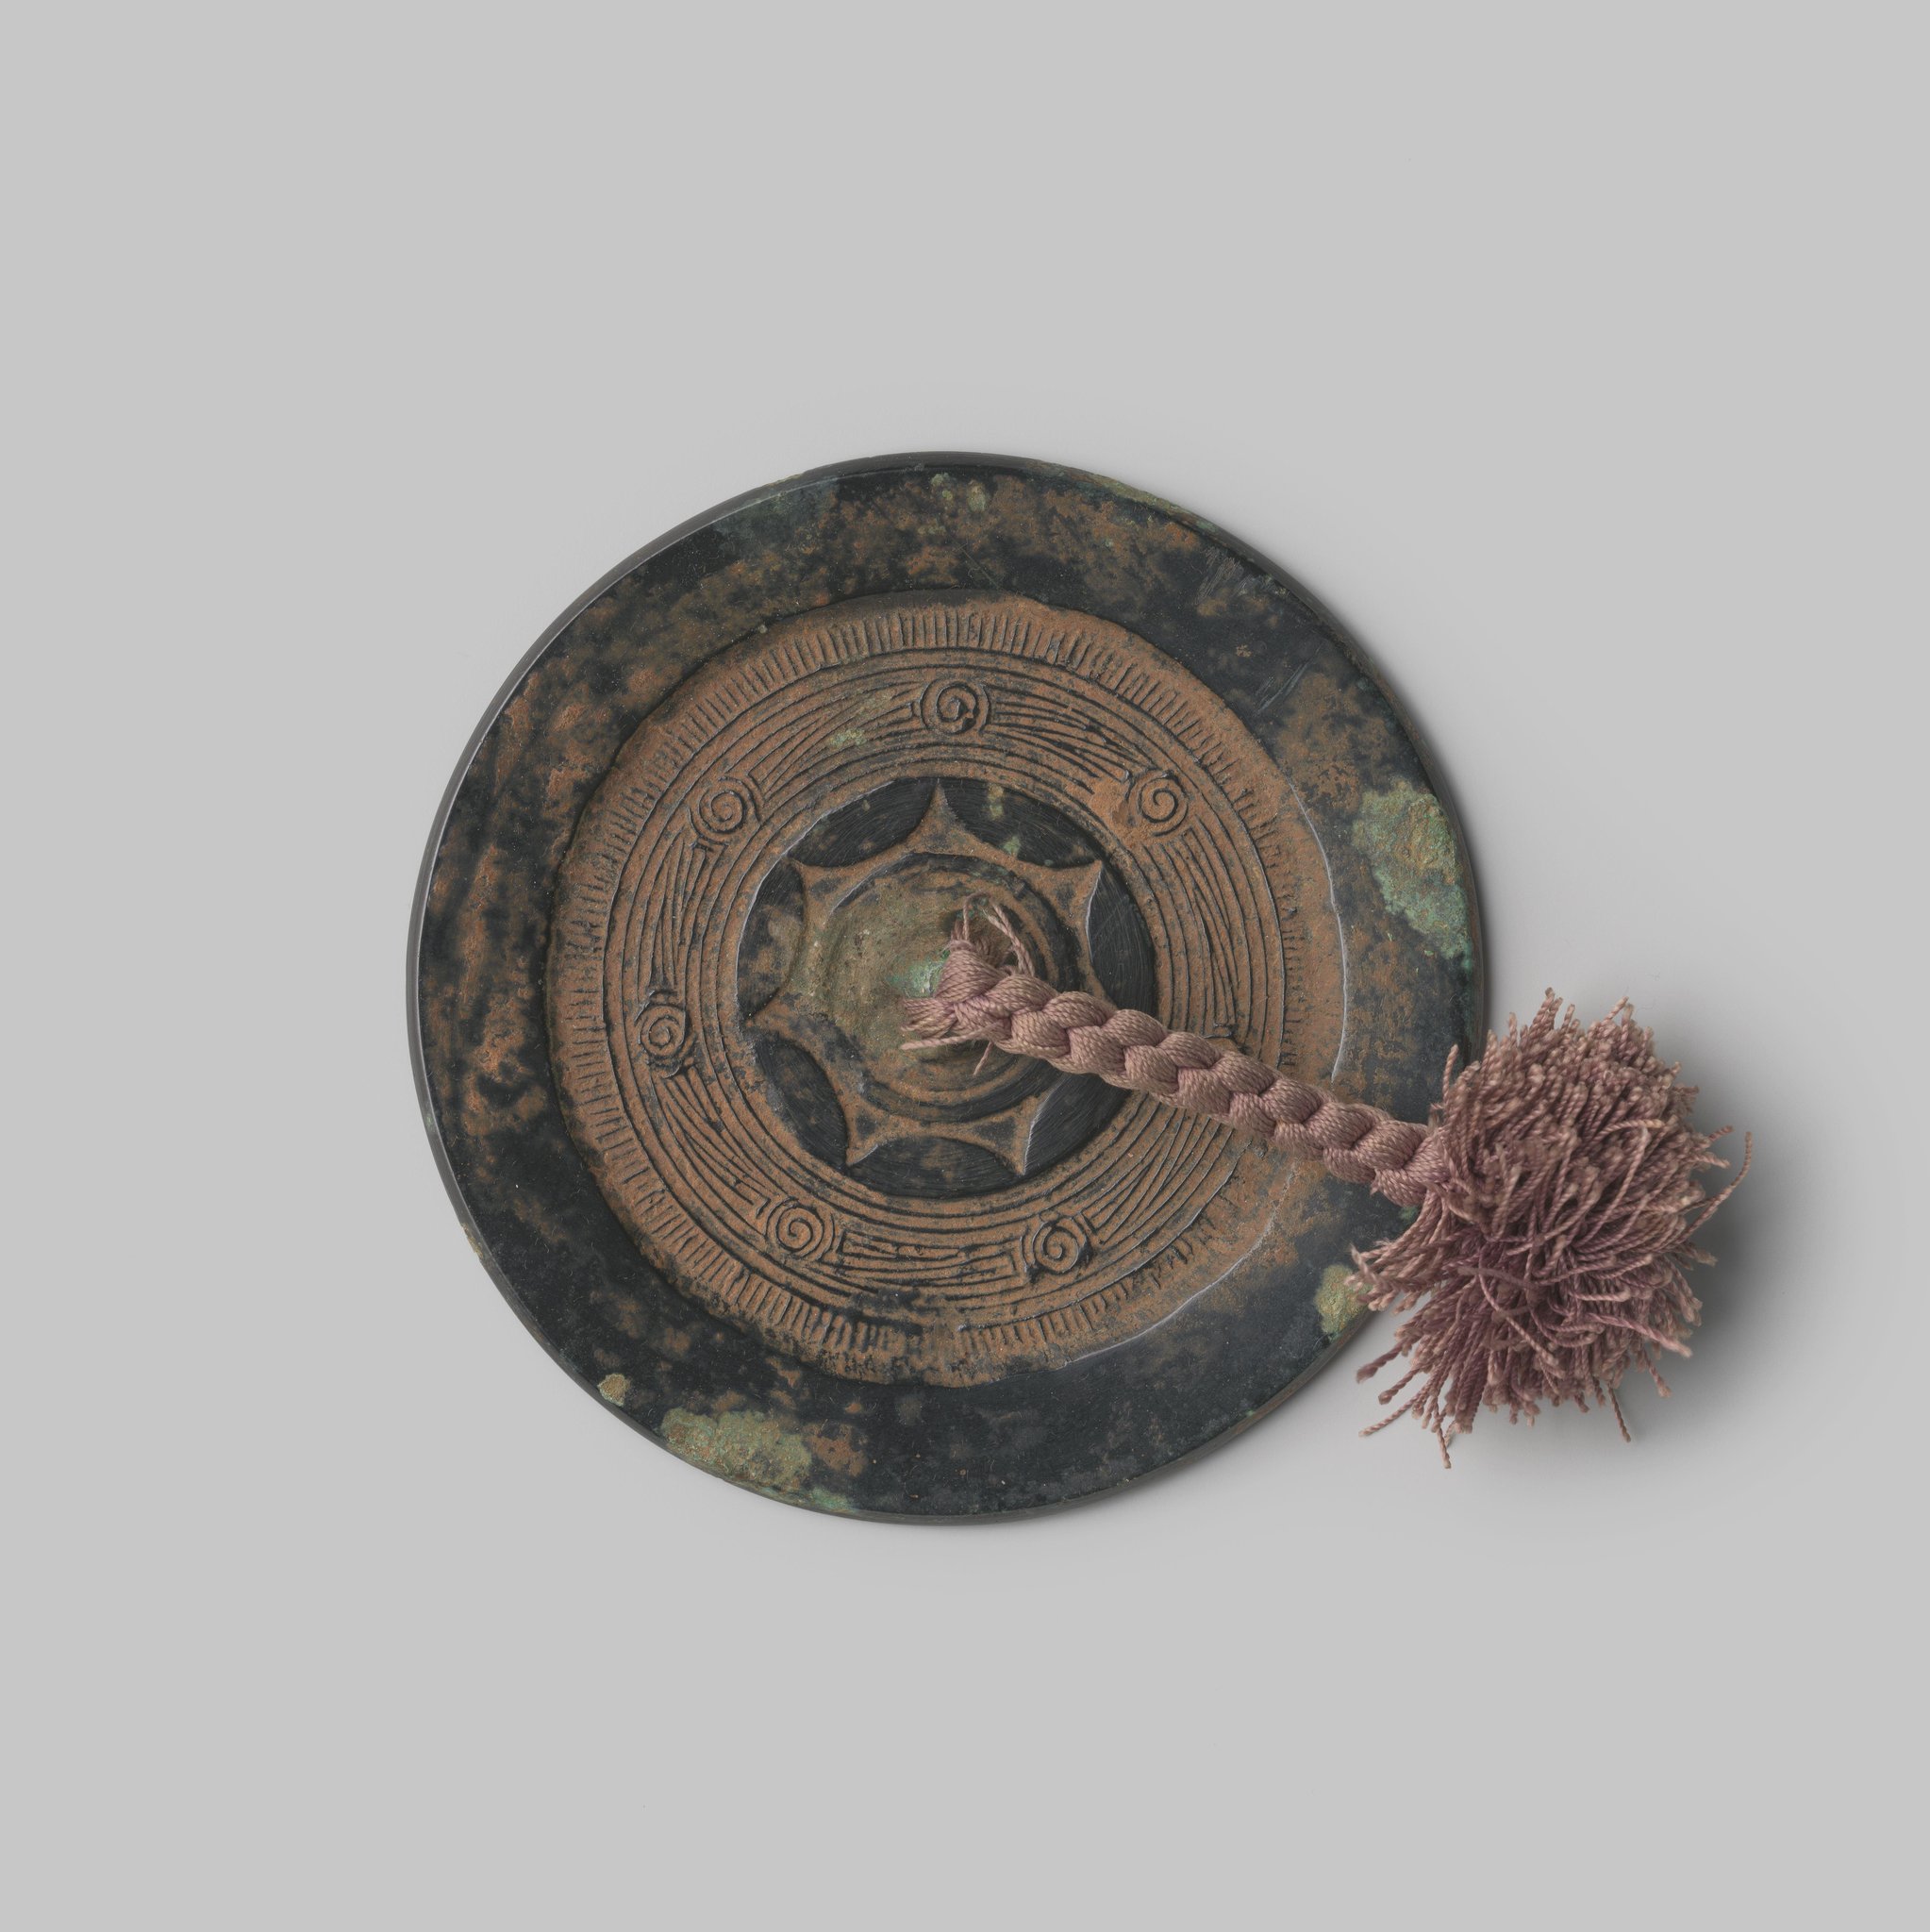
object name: mirror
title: Spiegel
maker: Anonymous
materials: bronze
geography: china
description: Spiegel uit de Han-tijd met zwarte glanzende patina.